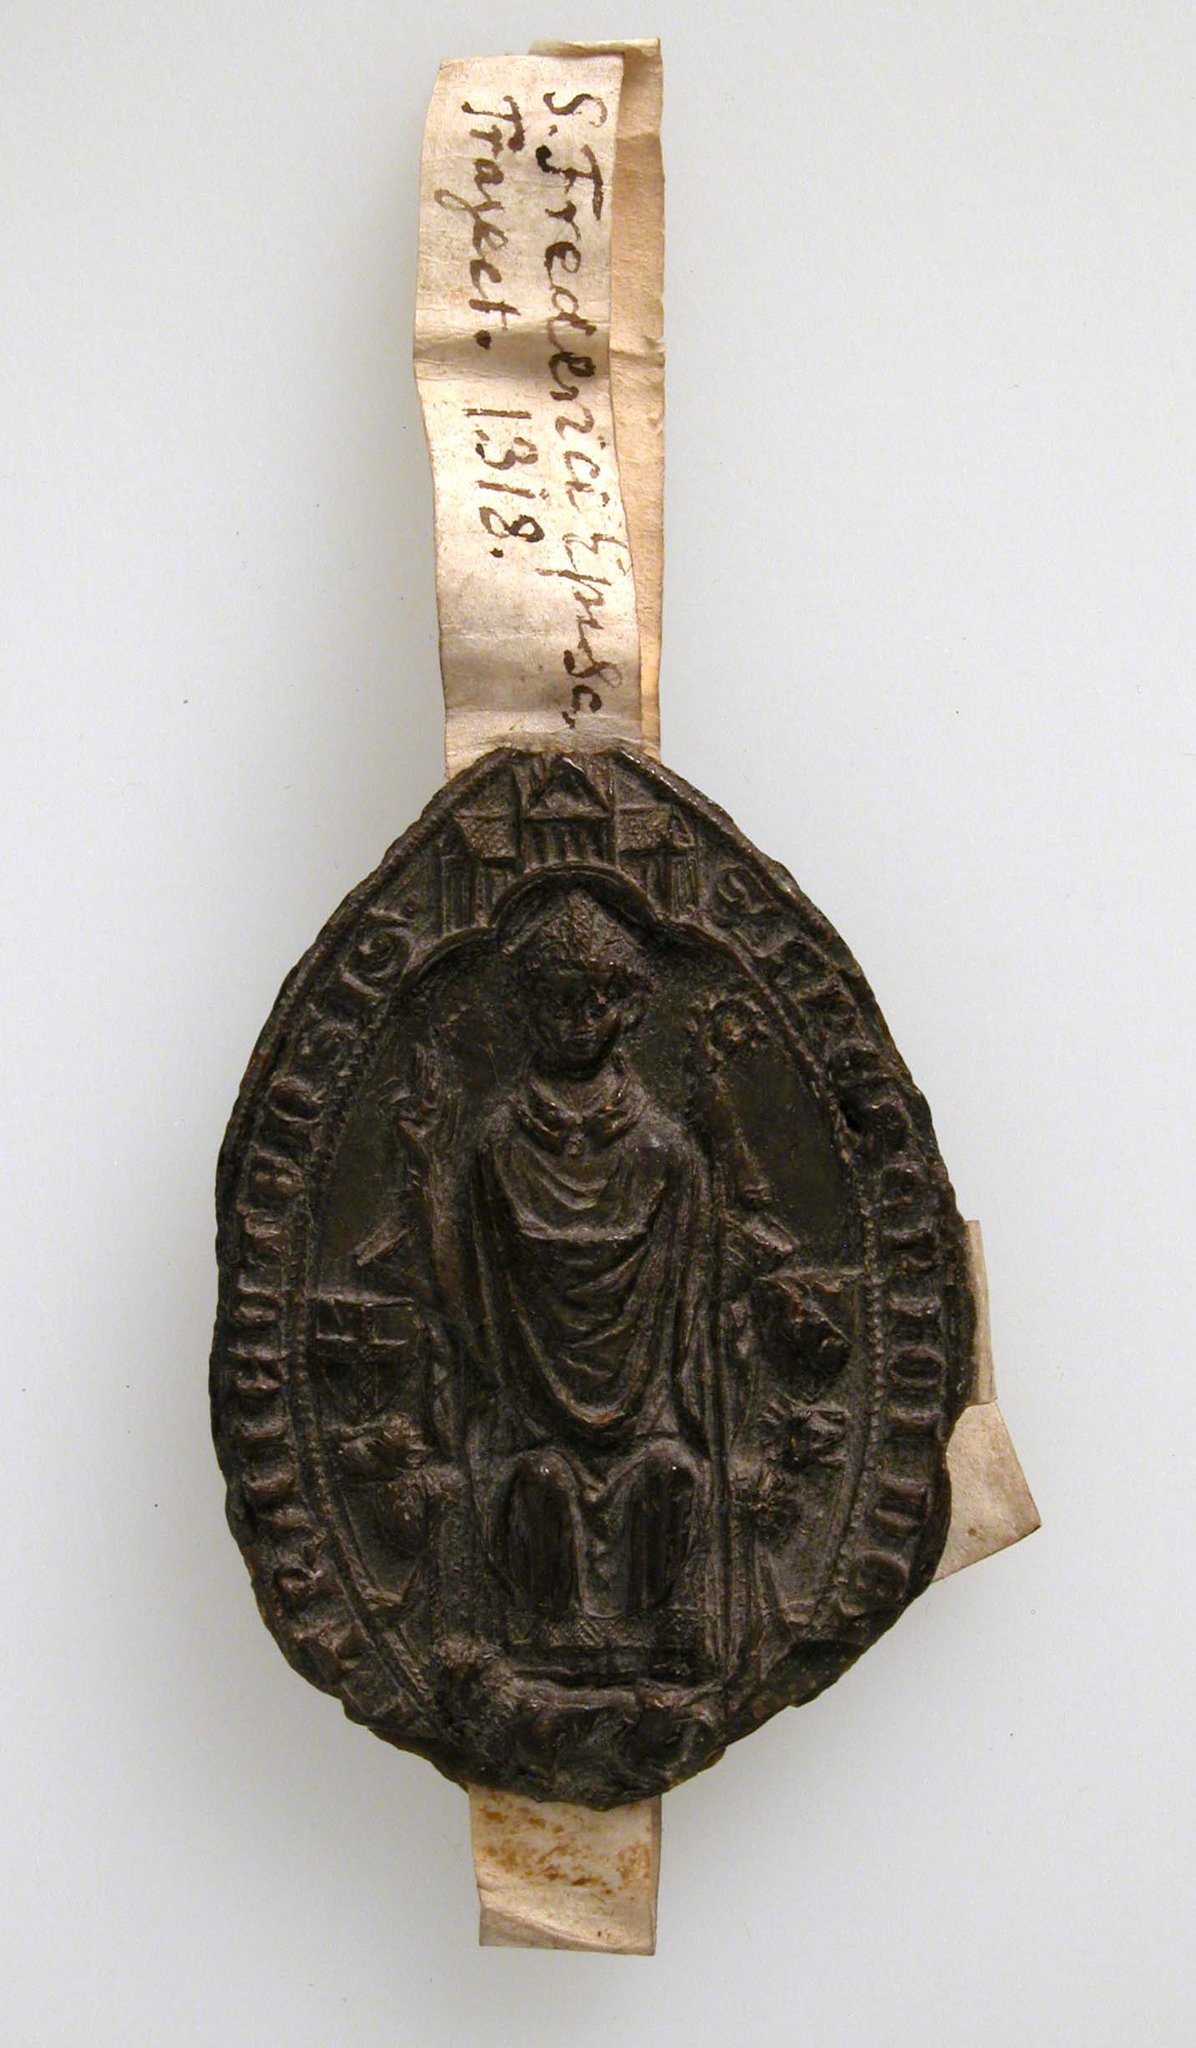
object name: seal impression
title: Seal Impression, Bishop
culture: dutch or south lowlands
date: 1358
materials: wax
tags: bishops